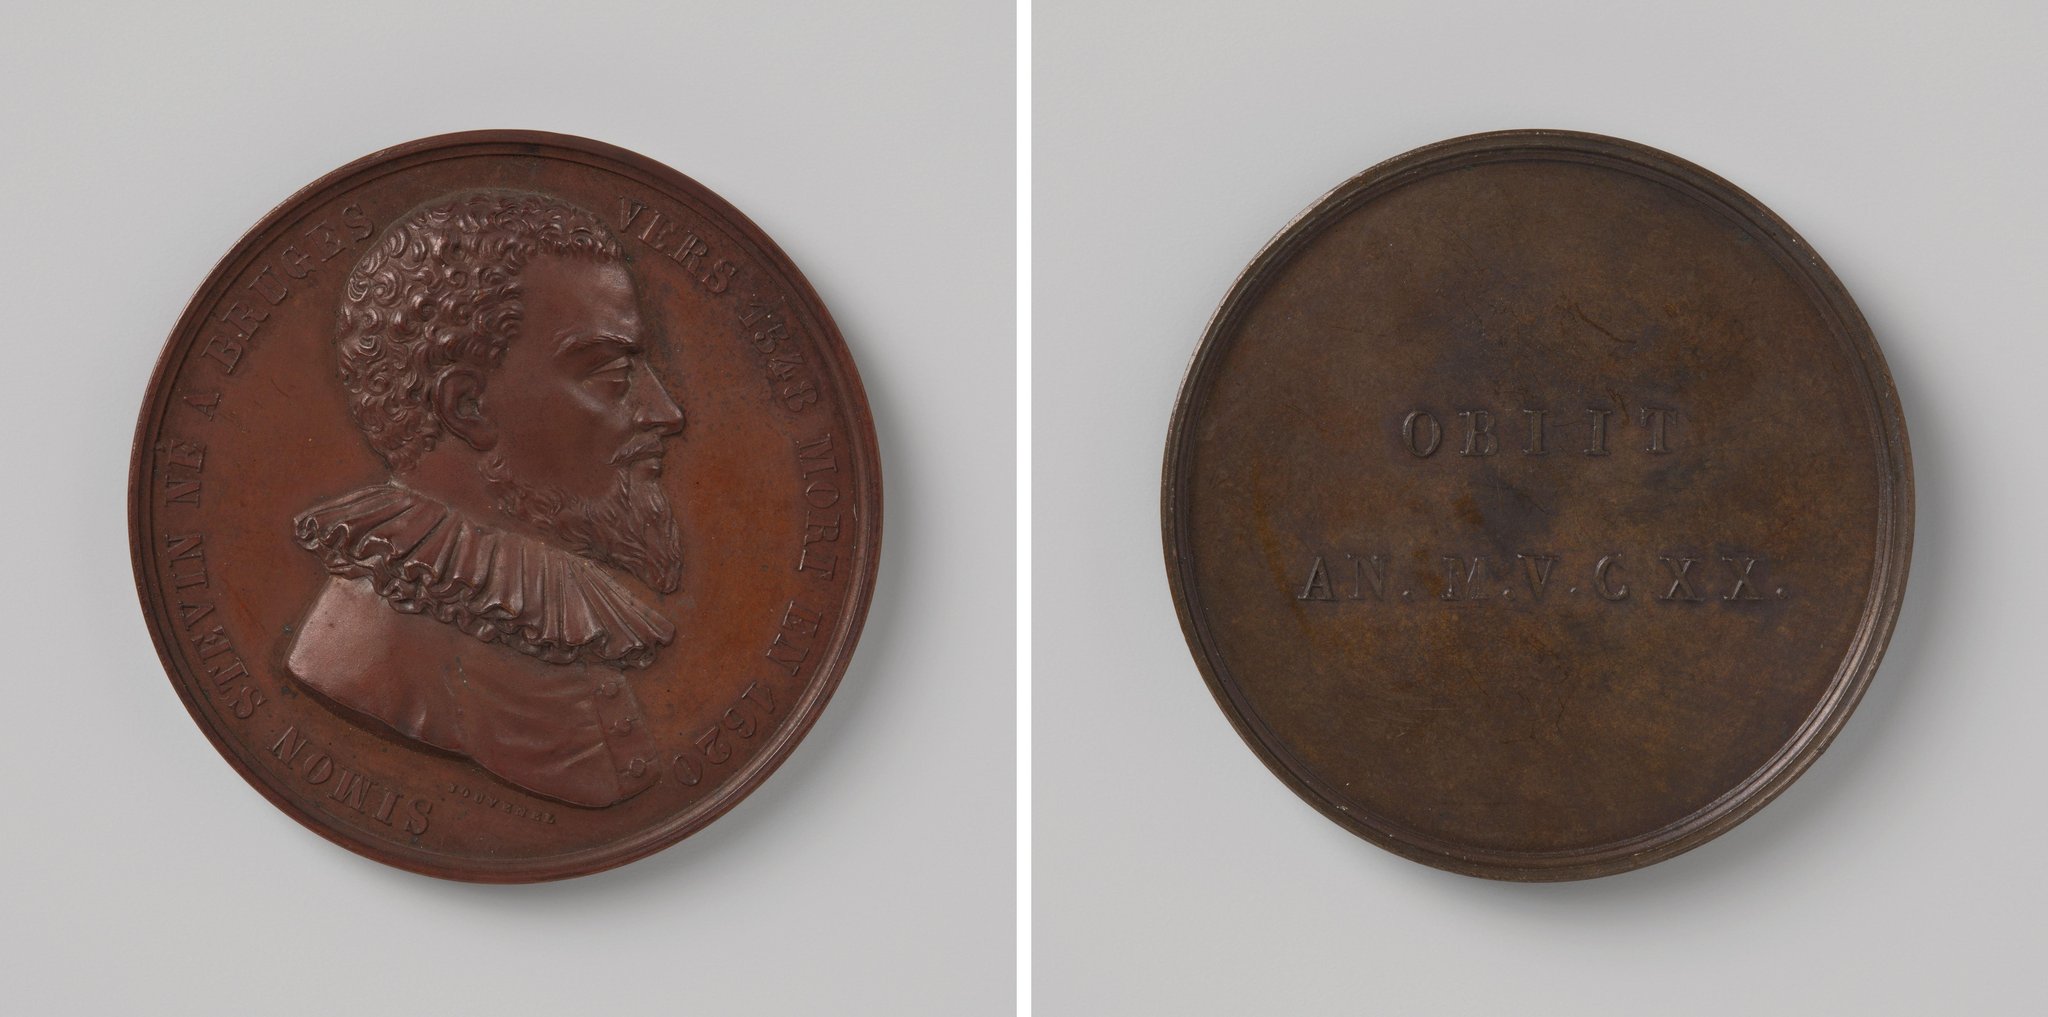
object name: history medal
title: Dood van Simon Stevin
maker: adolphe jouvenel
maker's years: 1798-1867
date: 1848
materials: bronze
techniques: striking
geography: brussels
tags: simon stevin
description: Bronzen penning. Voorzijde: borststuk man binnen omschrift. Keerzijde: wetenschappelijke apparatuur met opschrift er onder